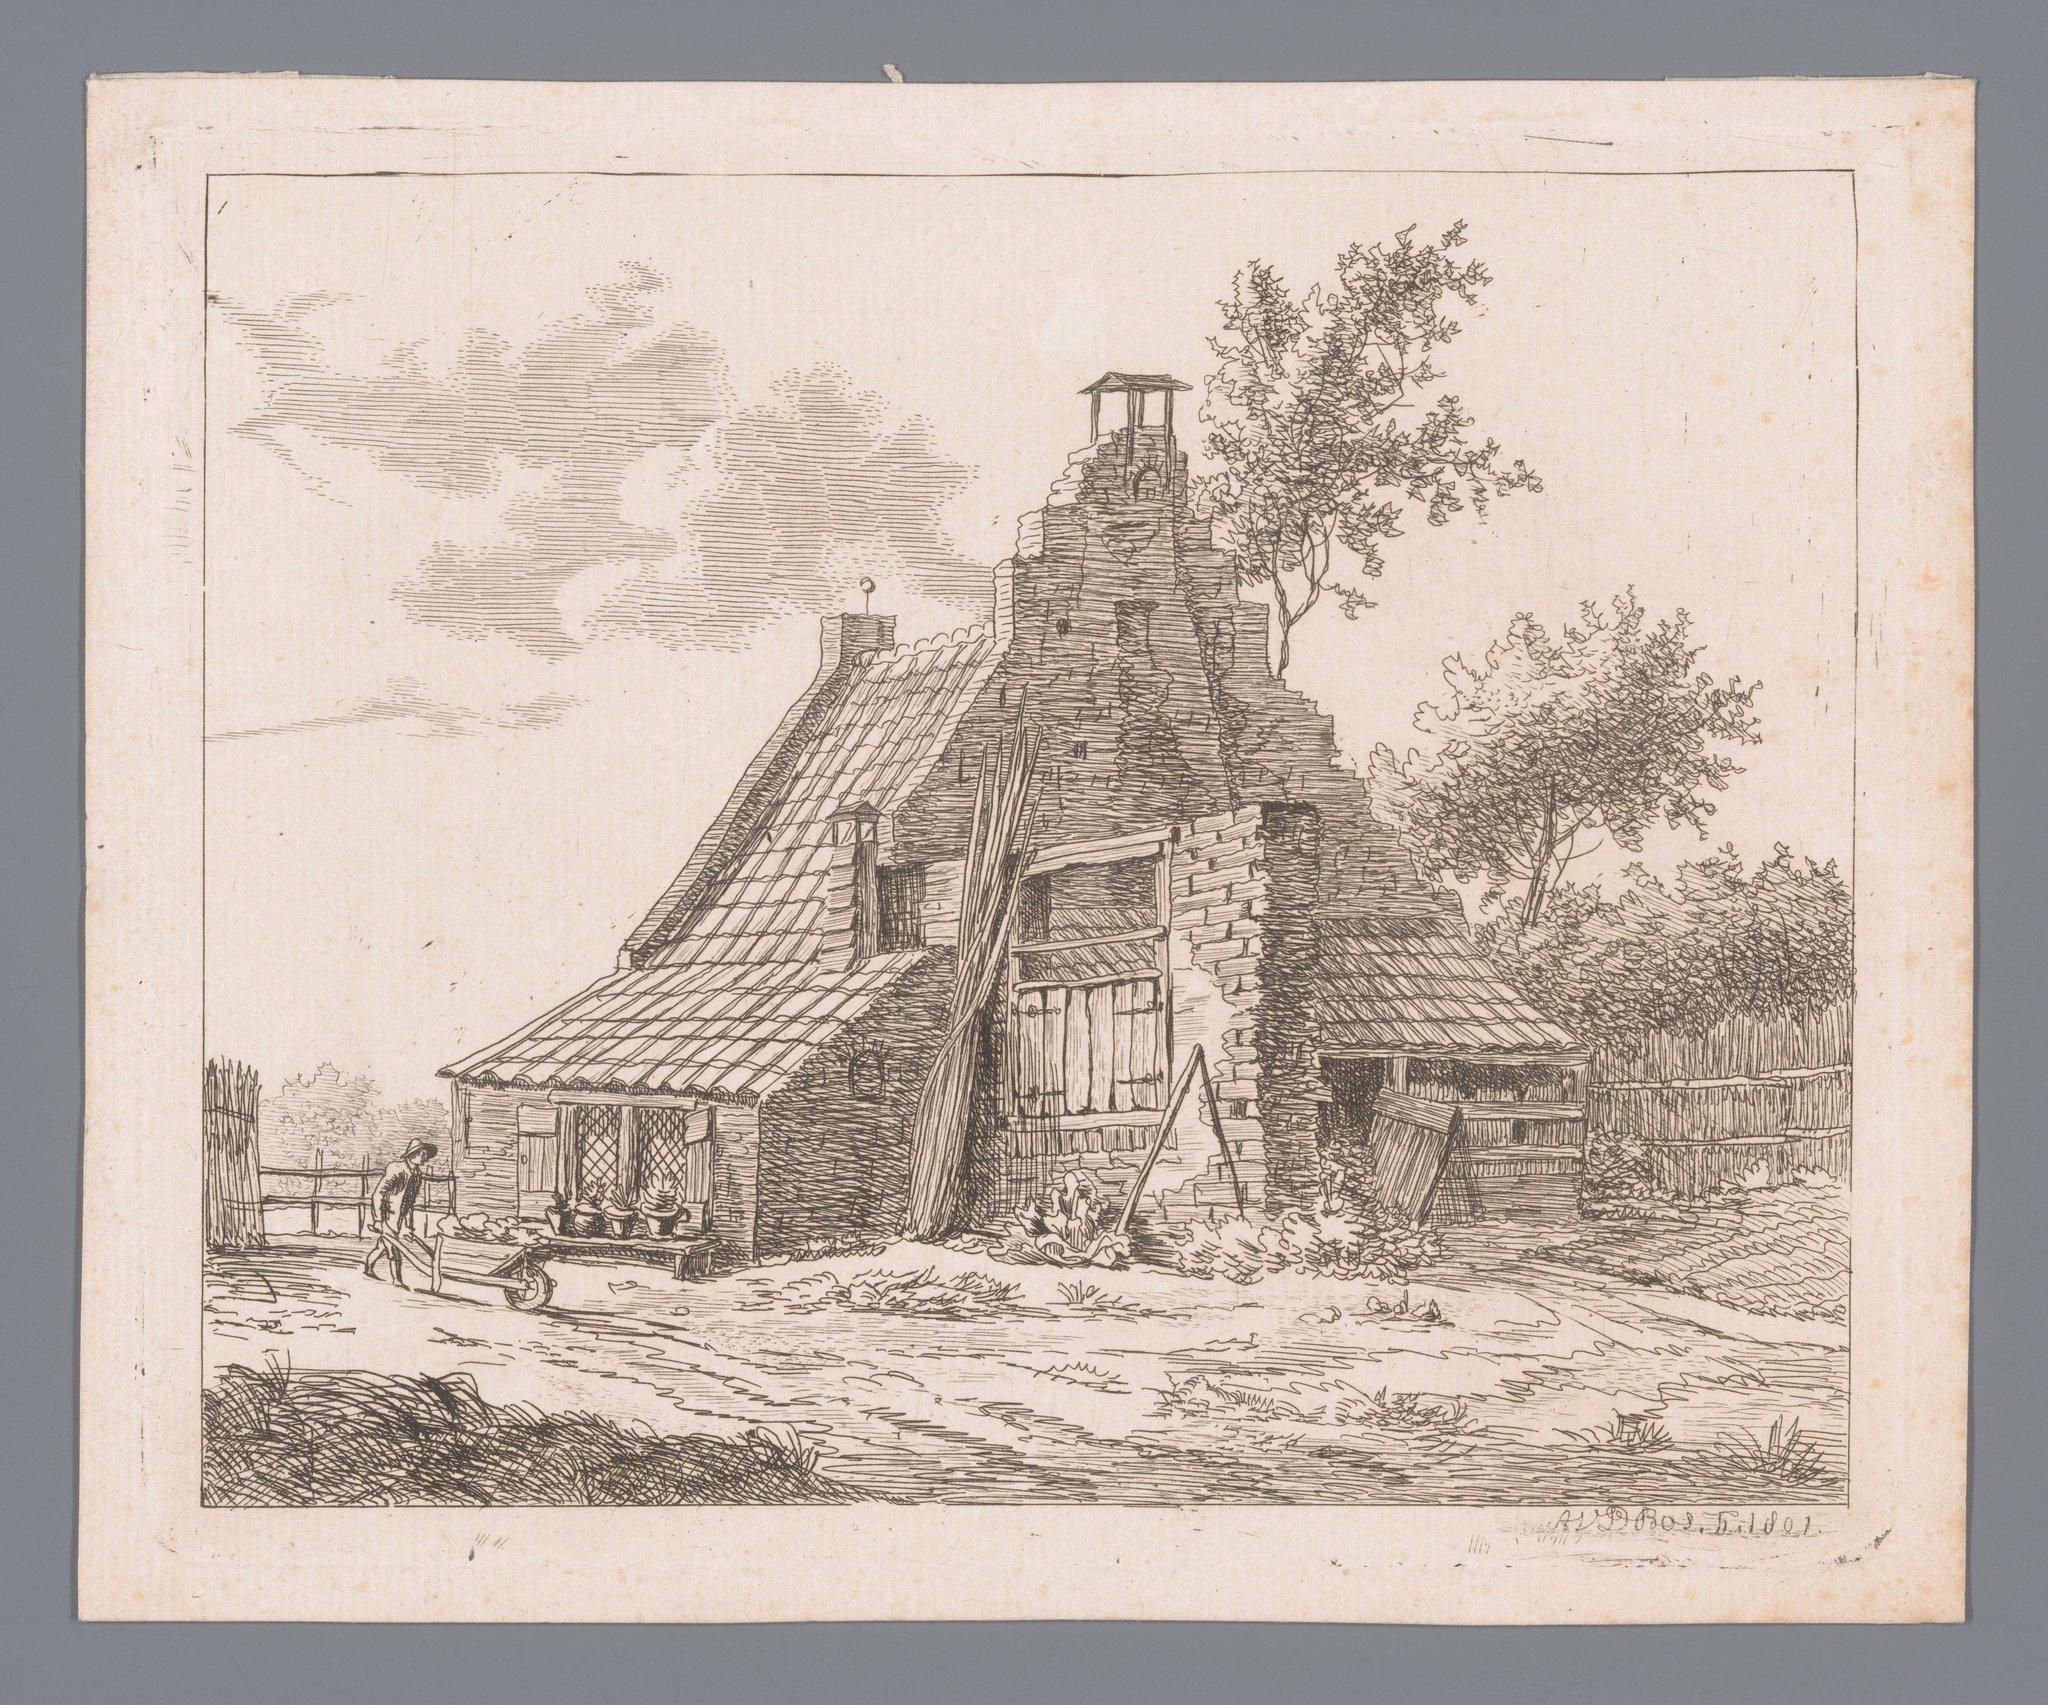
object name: print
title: Ruïne van het huis Snaatburg te Maarssen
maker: anthonie van den bos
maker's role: draughtsman, print maker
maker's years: 1763-1838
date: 1801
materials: paper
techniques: etching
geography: netherlands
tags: ruin of a dwelling, house, castle, etc., maarssen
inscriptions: collector's mark: Lugt 2228